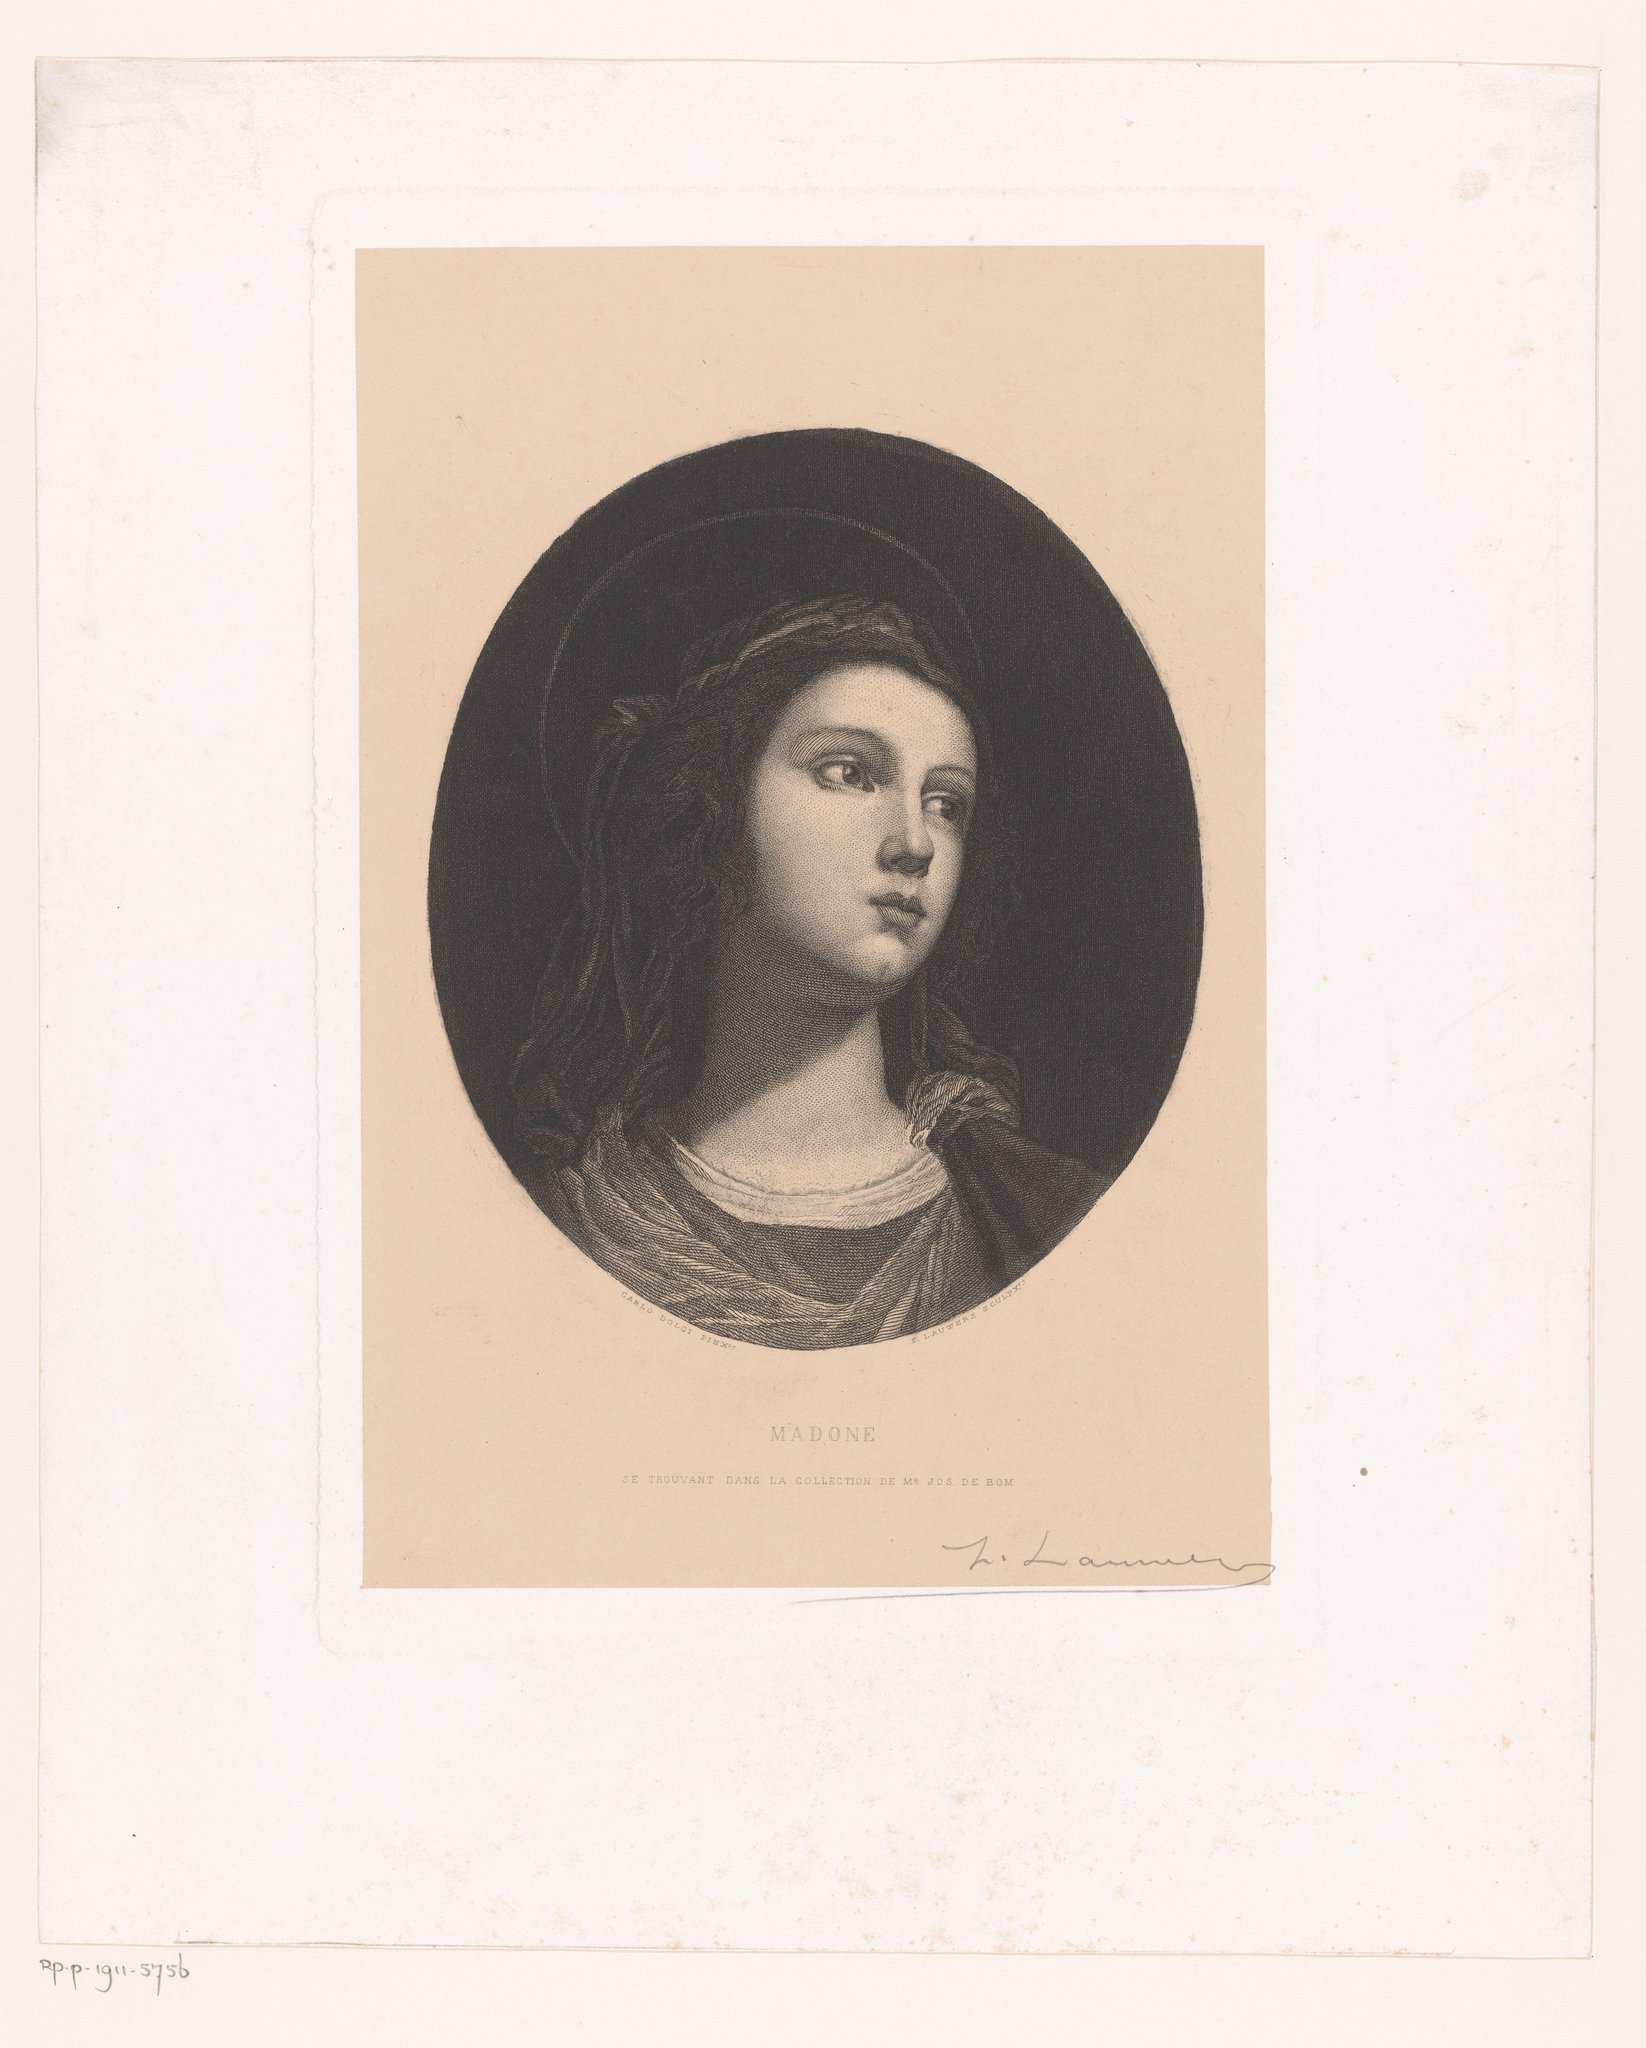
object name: print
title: Madone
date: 1864-1911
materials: paper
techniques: etching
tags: 'portraits' of mary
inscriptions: collector's mark: Lugt 2228